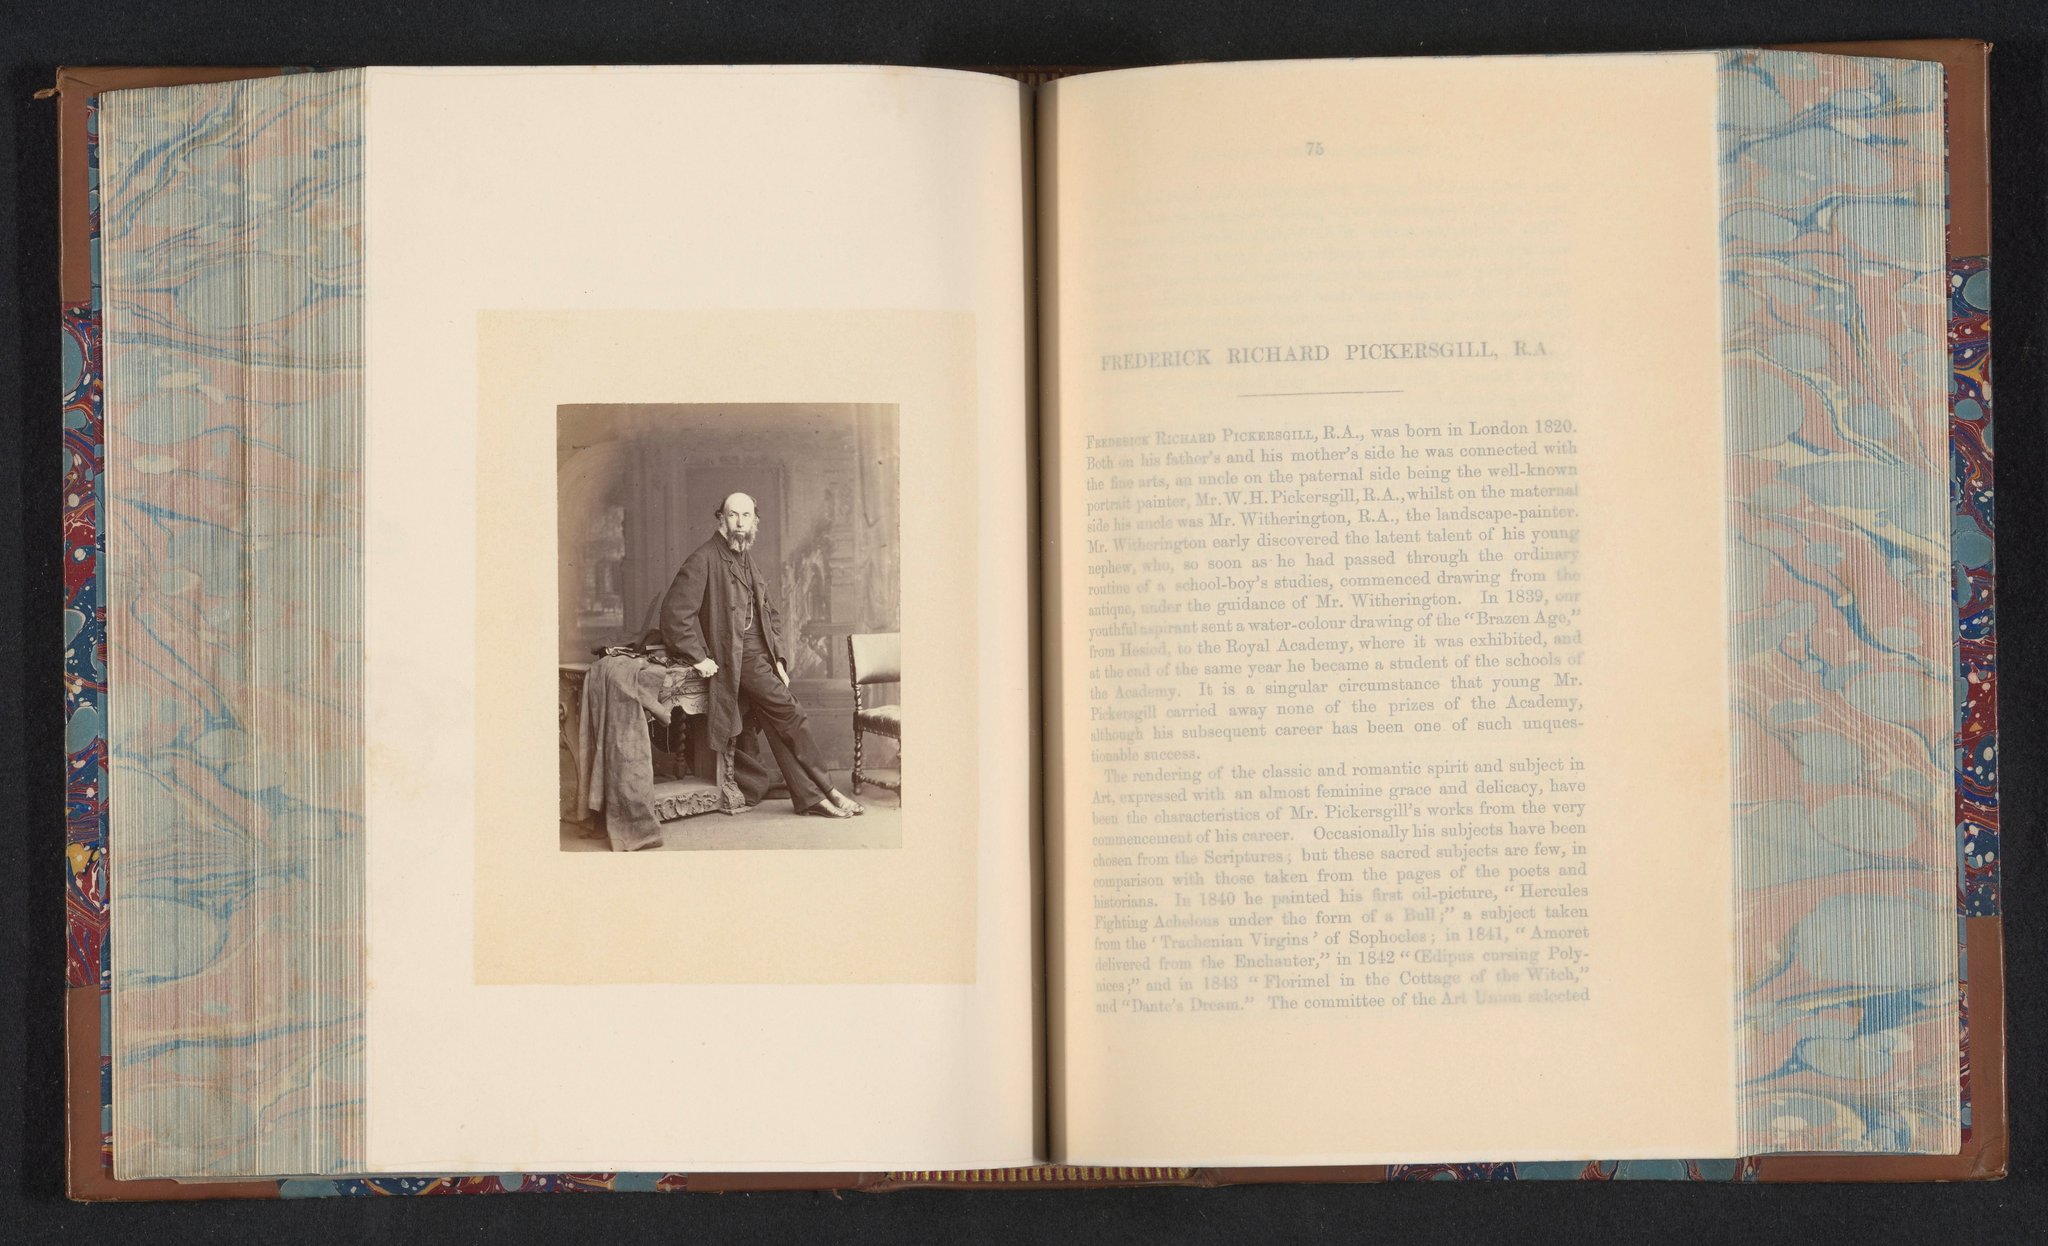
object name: photograph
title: Portret van Frederick Richard Pickersgill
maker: ernest edwards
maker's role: fotograaf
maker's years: 1837-1903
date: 1853-1867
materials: photographic support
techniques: albumen print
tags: painter, studio ~ photographer, portrait, self-portrait of painter